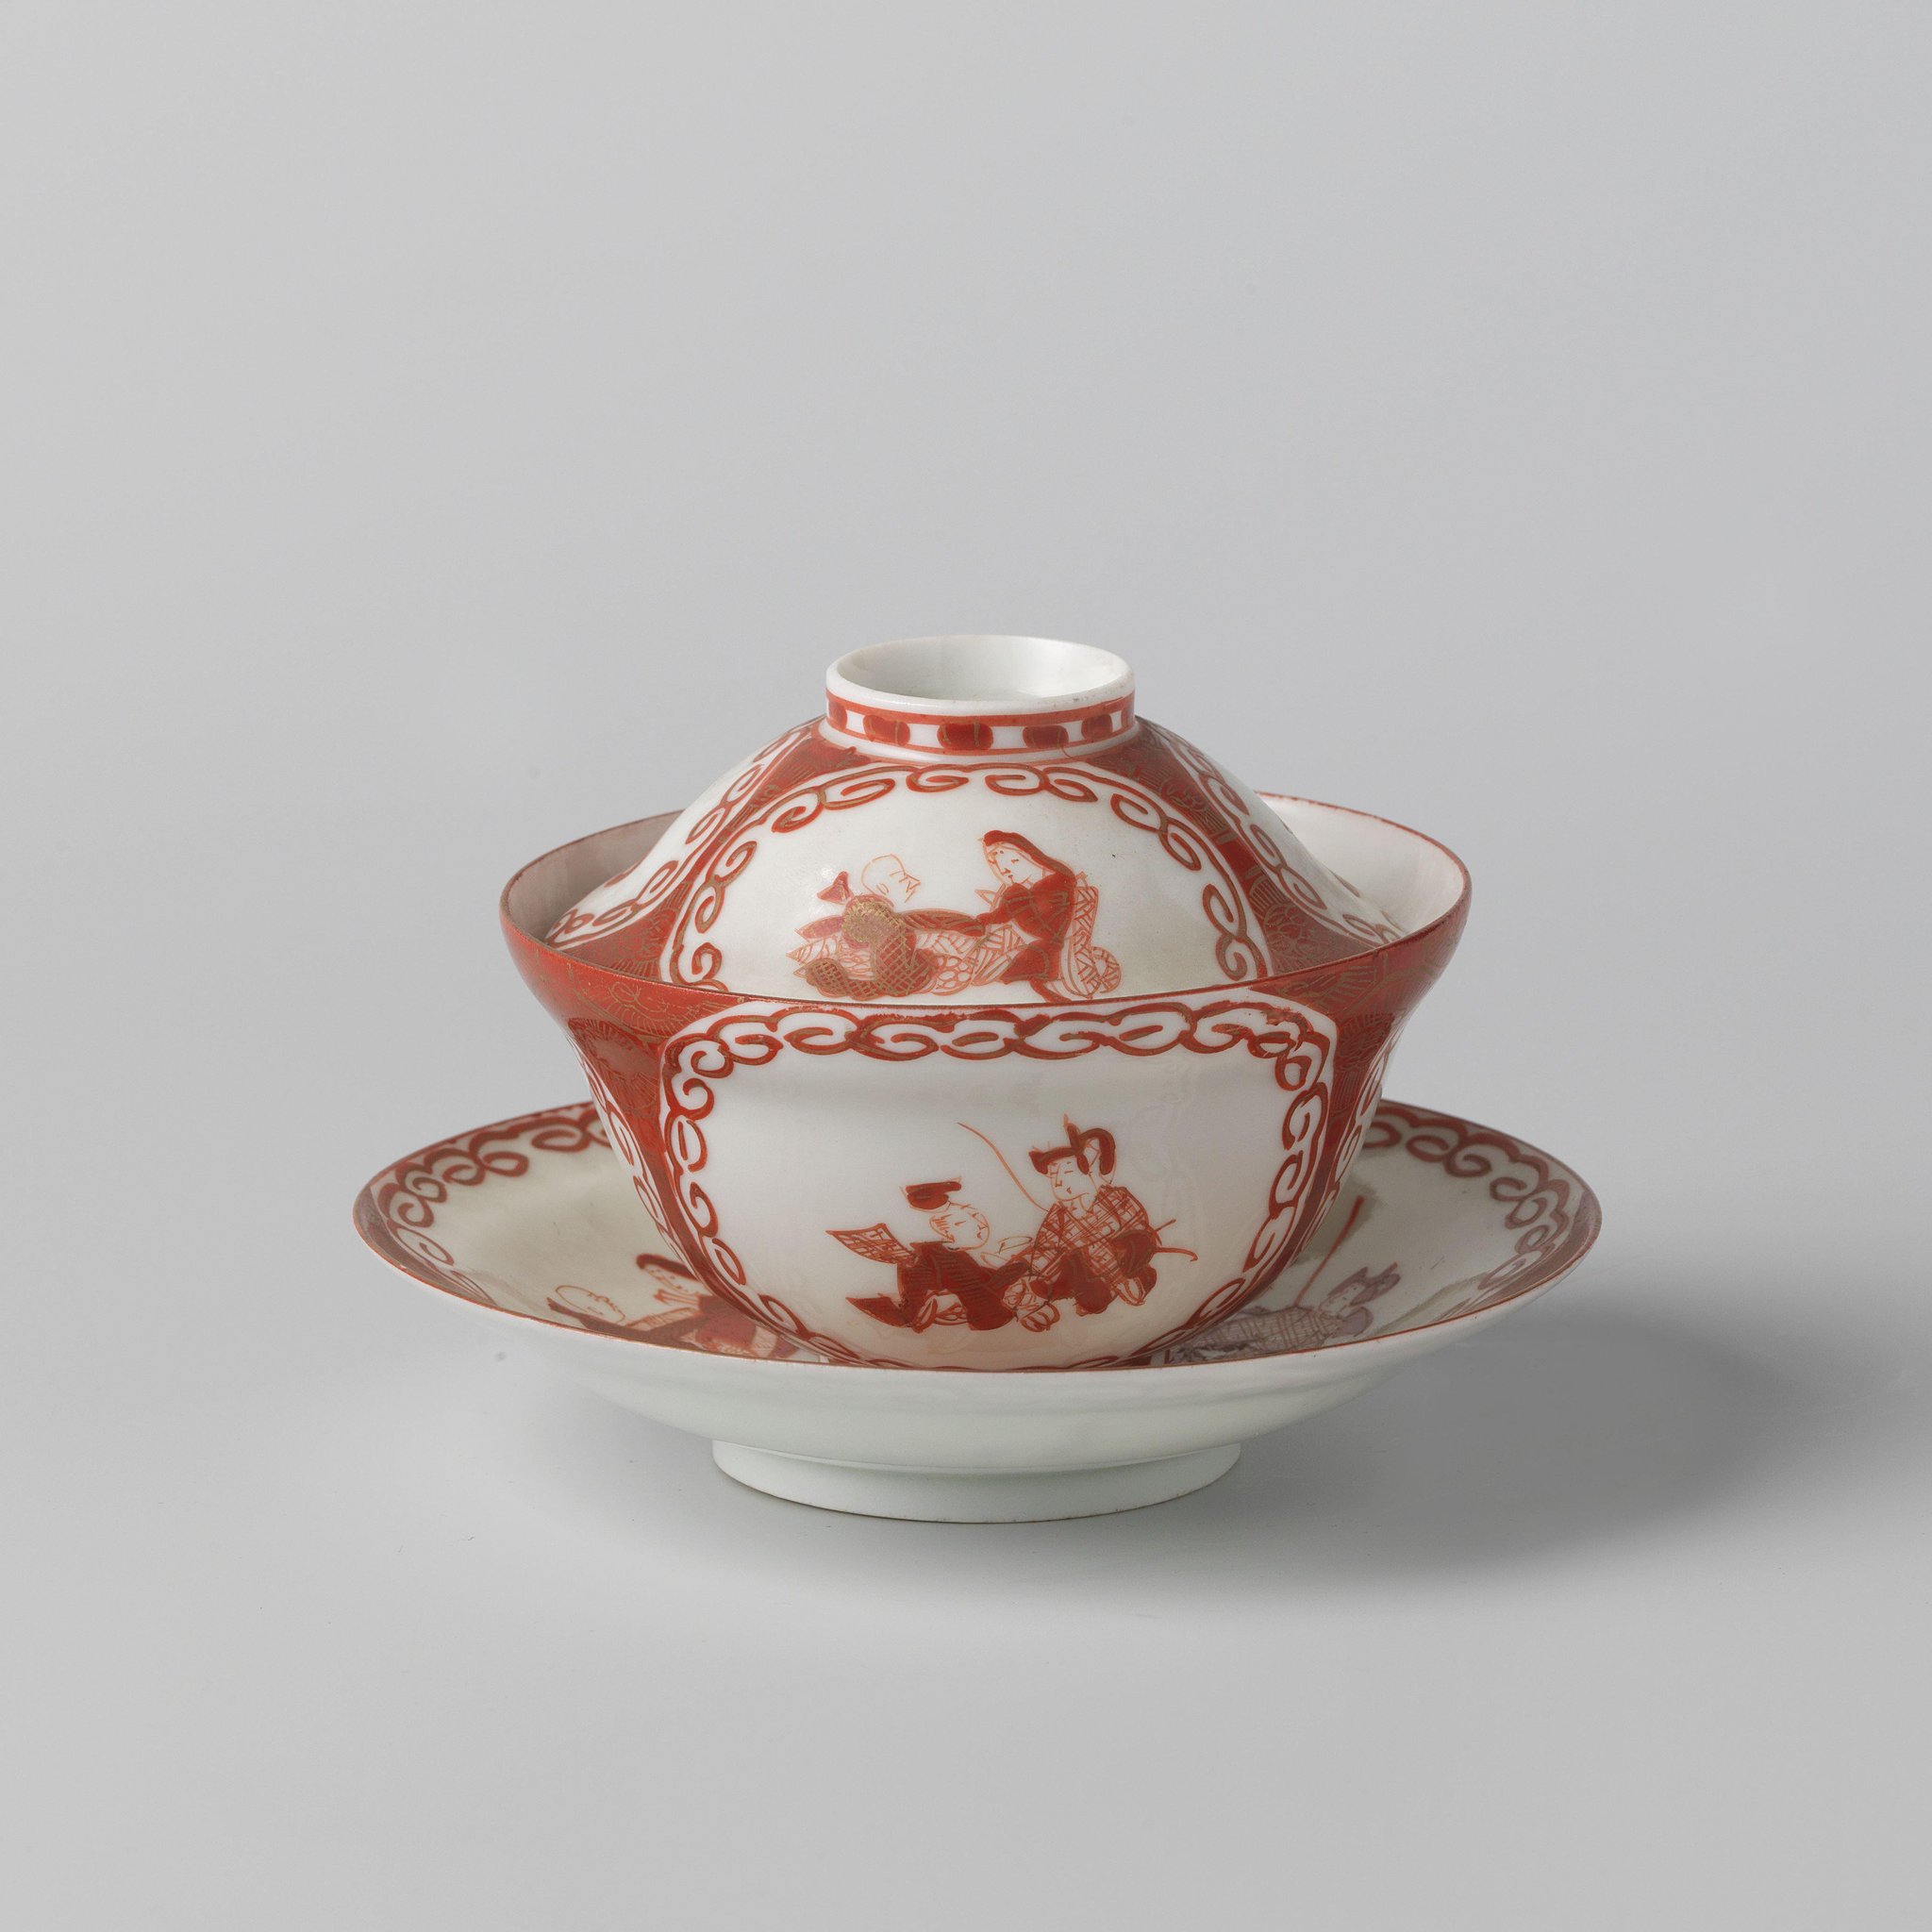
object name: lid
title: Covered cup and saucer with three panels with two seated figures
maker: Anonymous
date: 1800-1899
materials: glaze, gold, paint, porcelain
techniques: firing, gilding, turning, vitrification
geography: japan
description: Deksel van porselein met een ringvormige knop, beschilderd op het glazuur in rood en goud. Op de voorzijde van de deksel drie cartouches met telkens twee zittende mensen omgeven door een band krulwerk; tussen de cartouches een geometrisch patroon. Gemerkt op de onderzijde met drie ongeïdentificeerde karakters.